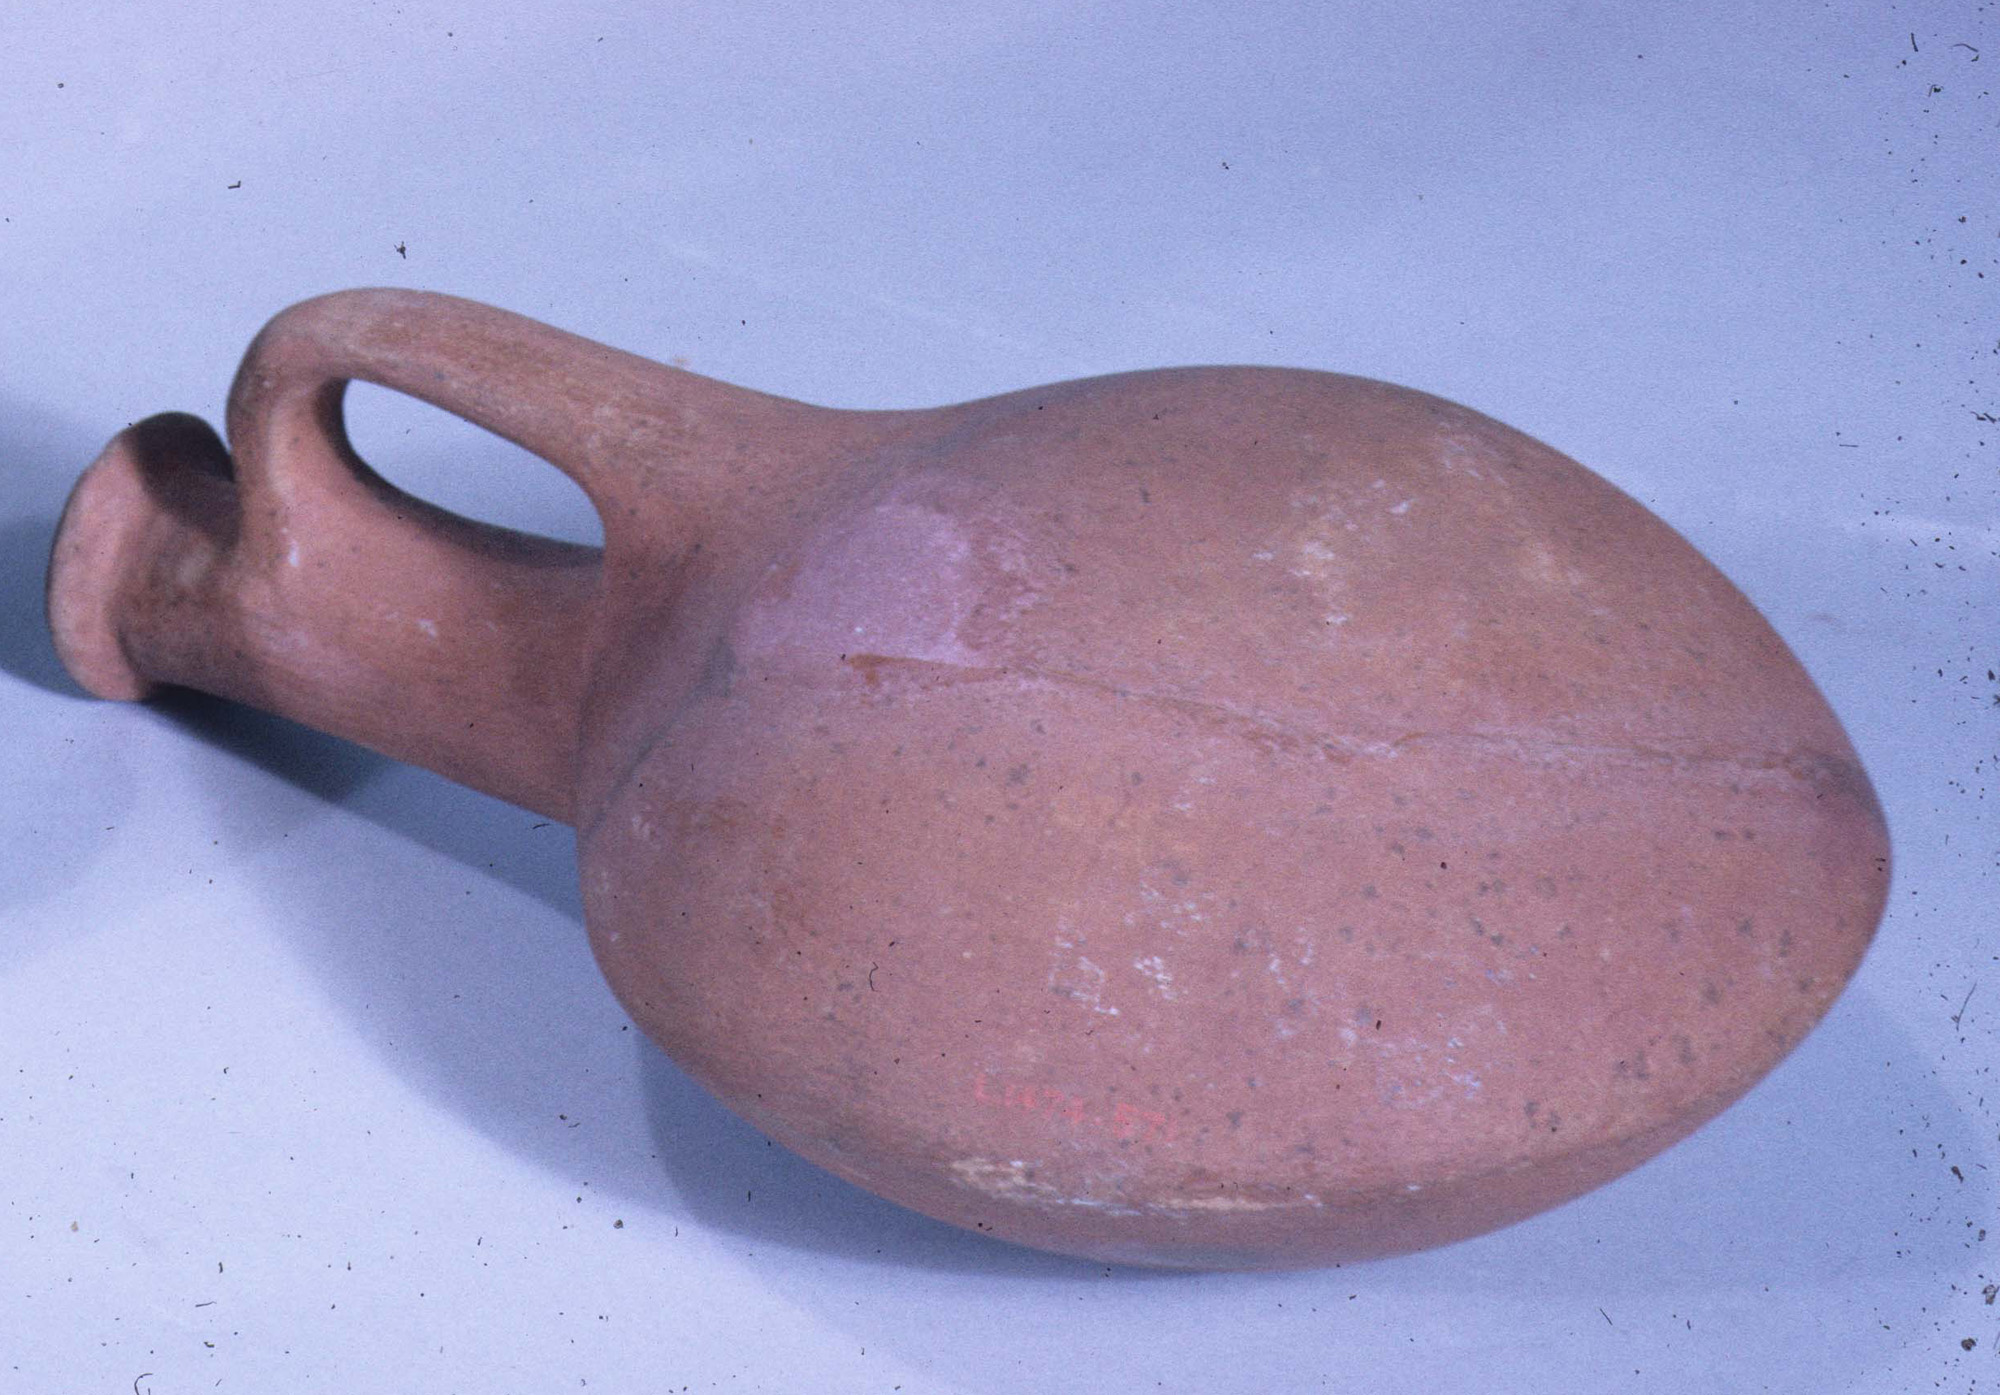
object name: jug, handled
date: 1550-1295 BCE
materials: pottery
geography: egypt